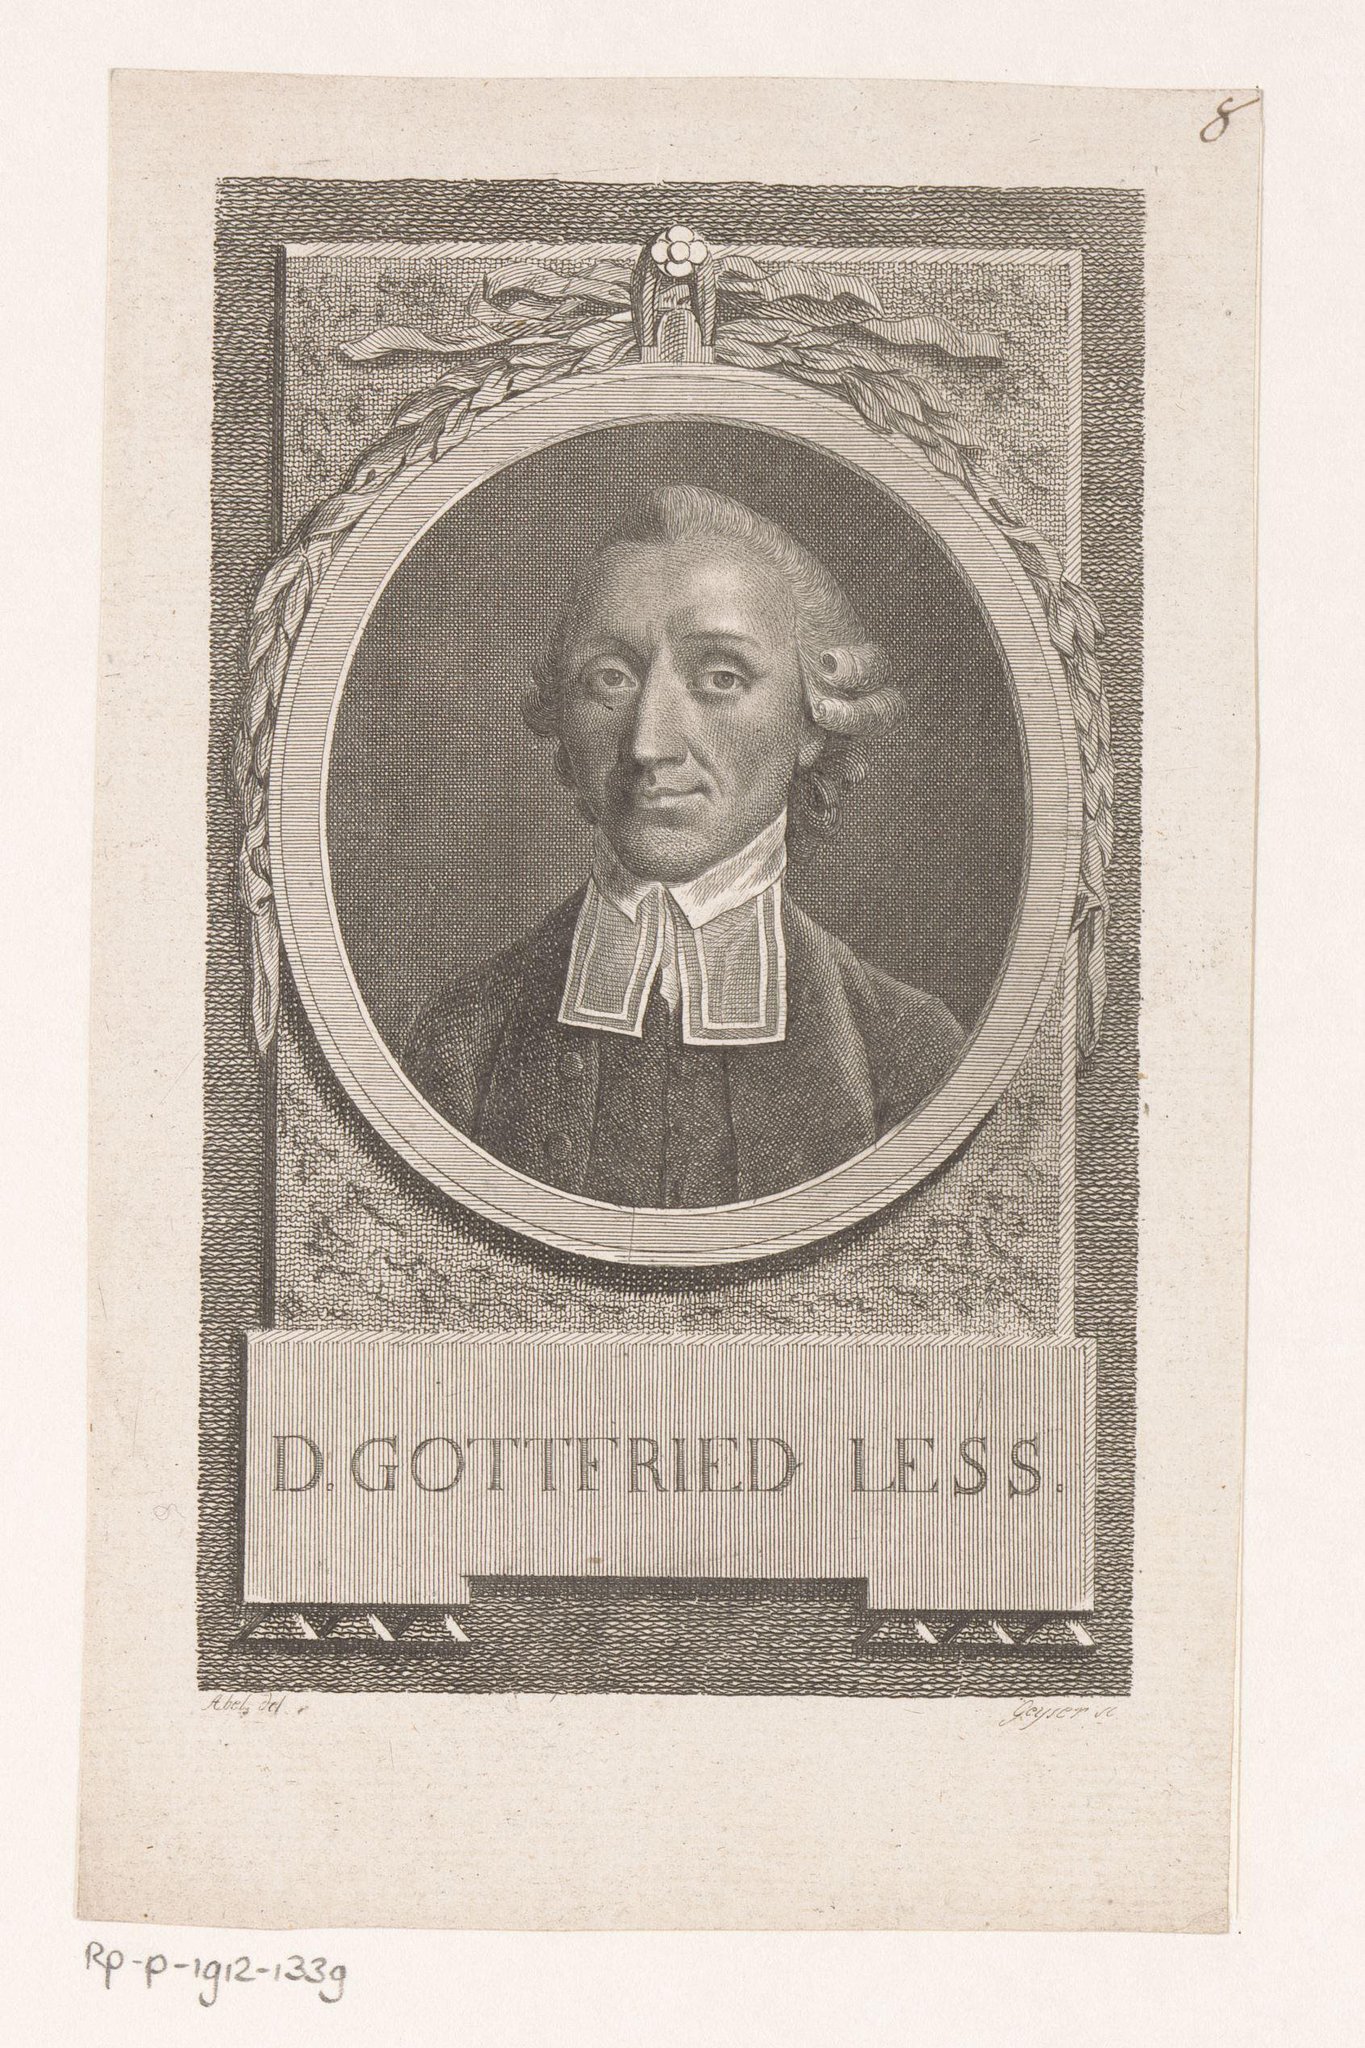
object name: print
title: Portret van Gottfried Less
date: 1752-1797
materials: paper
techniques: engraving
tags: poland, theologian, ornament ~ medallion, historical persons, ornament ~ festoon, garland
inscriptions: collector's mark: Lugt 2228